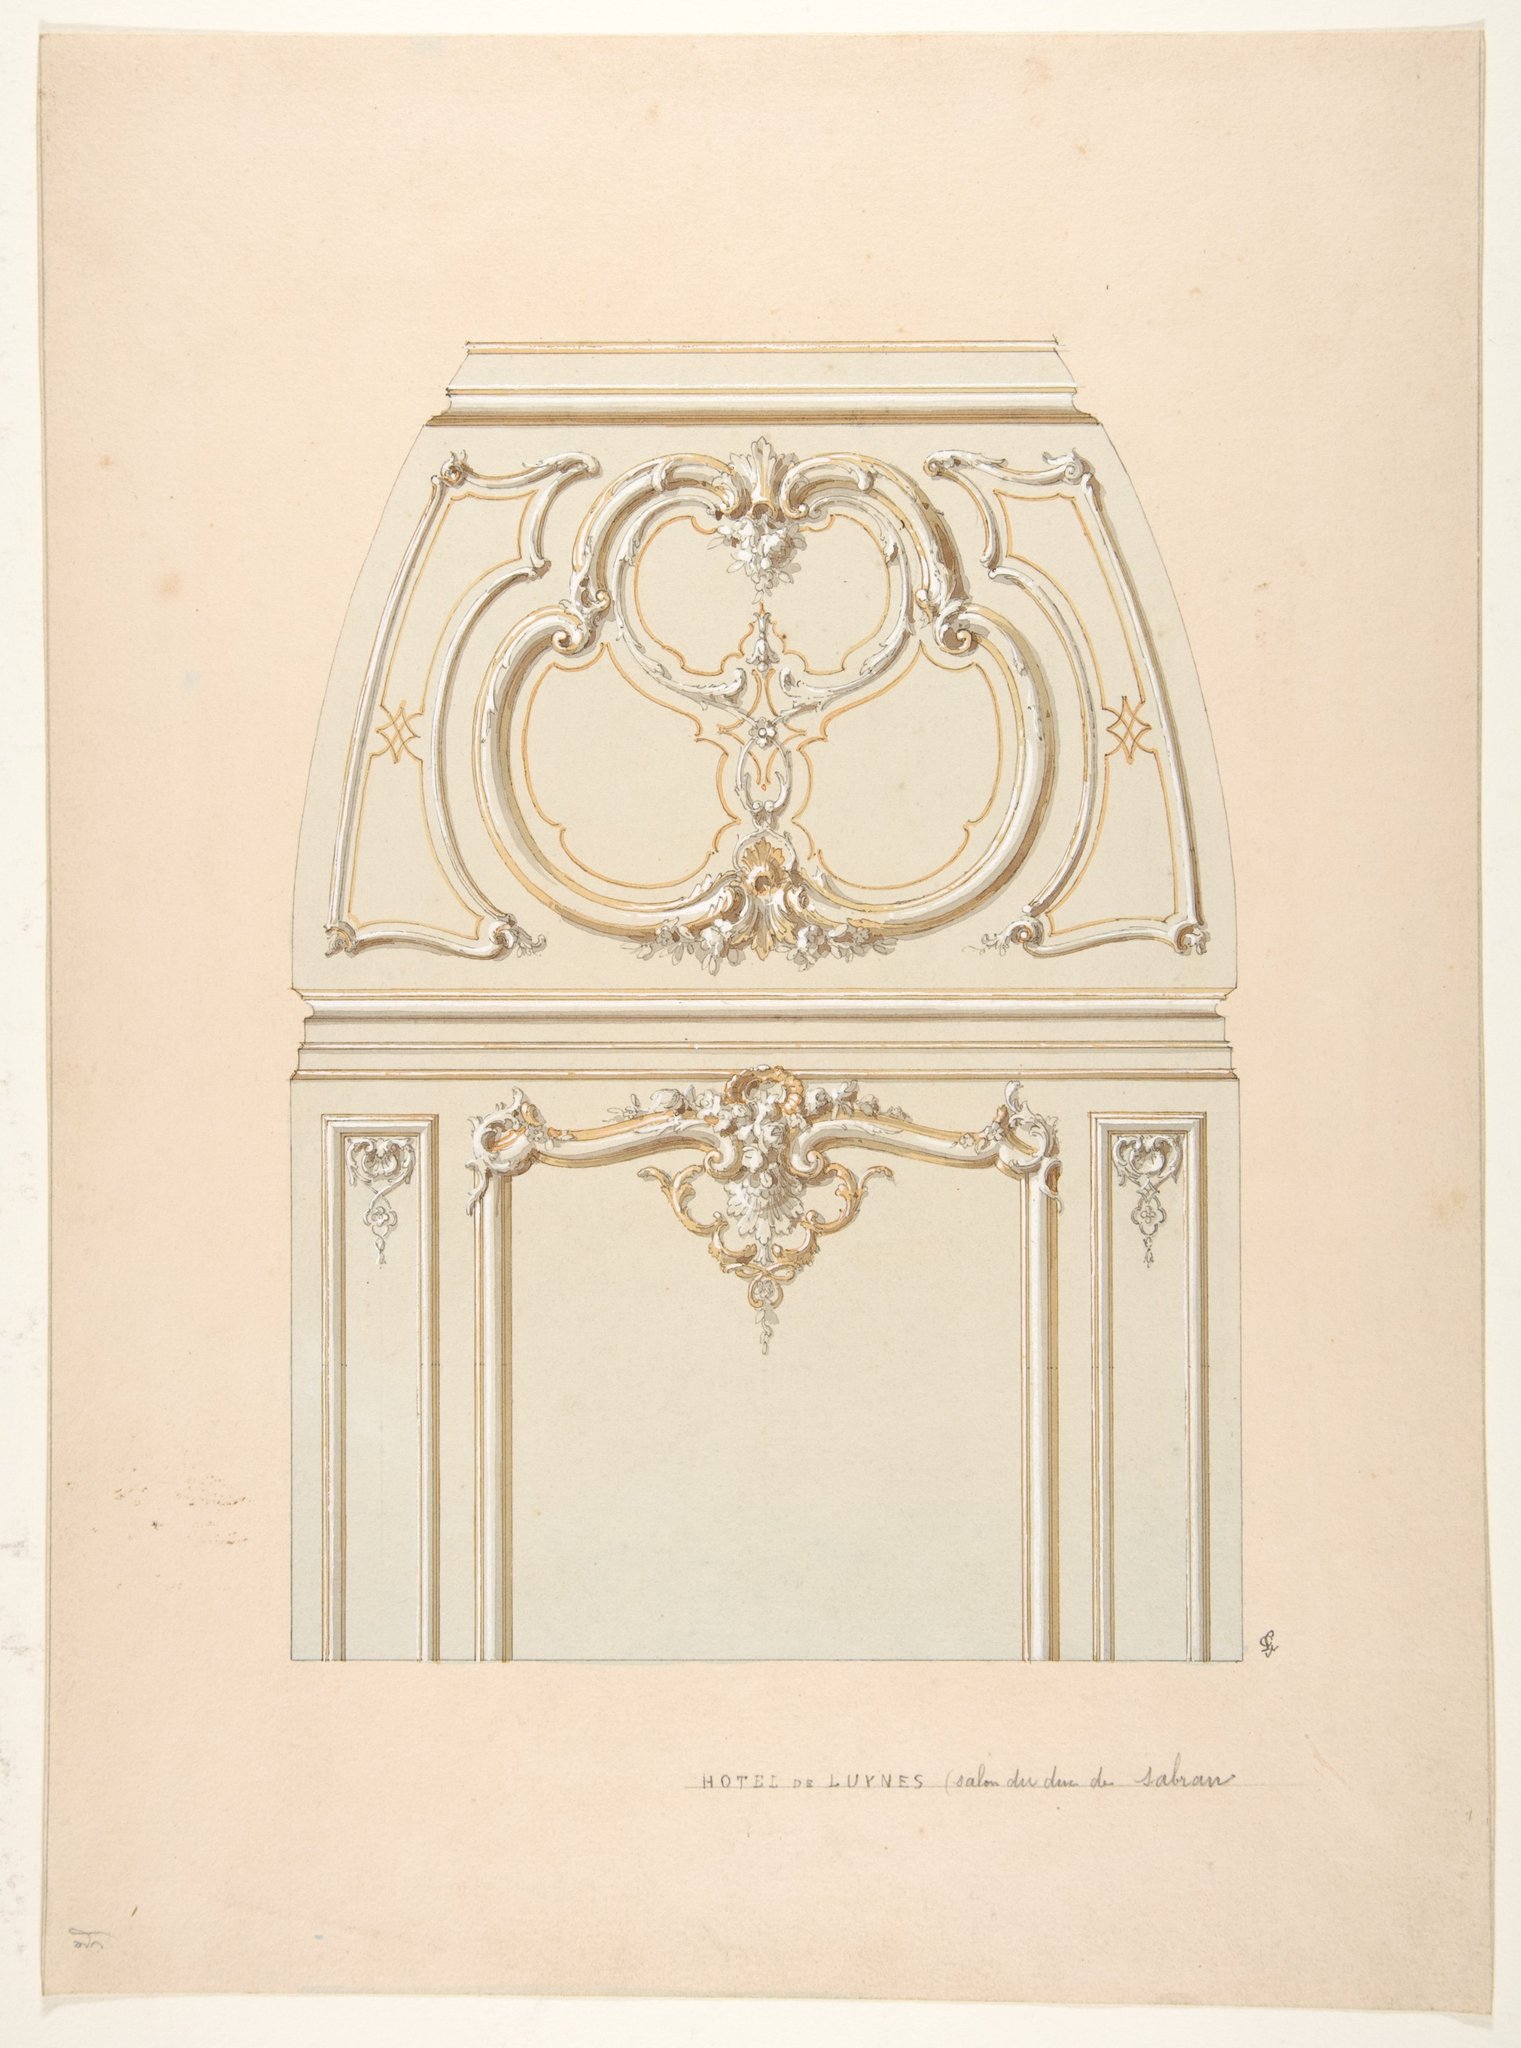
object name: drawing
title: Design for Rococco-style wall and cove ornament in the salon of the Hotel de Luynes, owned by the Duc de Sabran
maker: jules-edmond-charles lachaise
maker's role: artist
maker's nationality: french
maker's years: 1897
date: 1851-1900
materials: ink, watercolor, paper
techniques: pen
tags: architecture